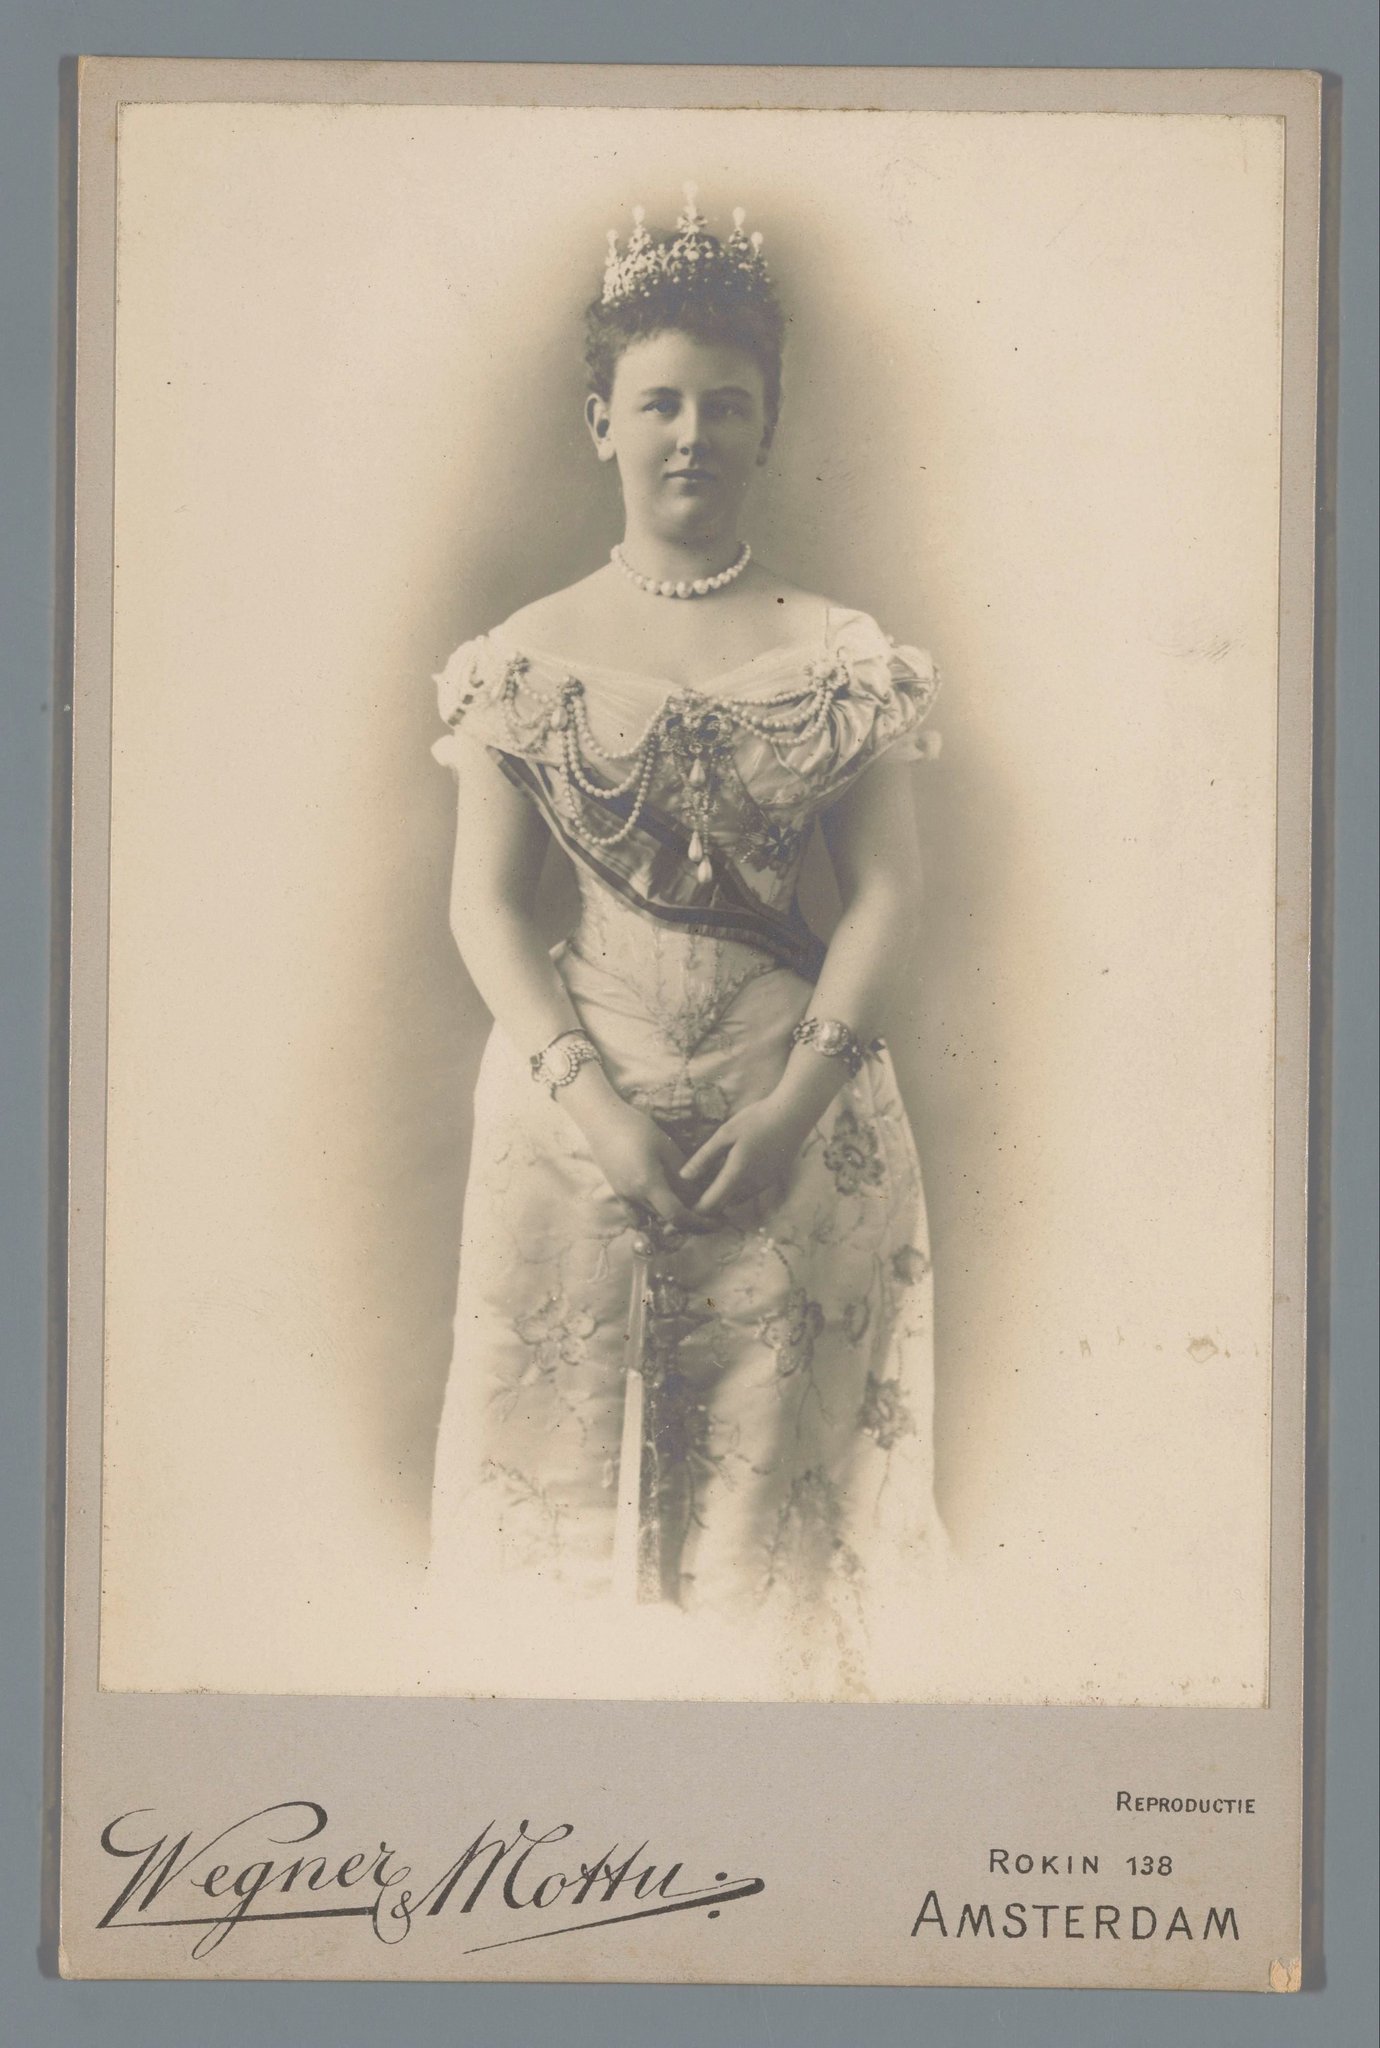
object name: cabinet photograph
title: Portret van koningin Wilhelmina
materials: cardboard, photographic support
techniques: gelatin silver print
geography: amsterdam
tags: the hague, print maker, wilhelmina of the netherlands, historical persons, queen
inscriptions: number: ‘40’, inscription: ‘December 1900?/ Wilhelmina/ 1899’, inscription: ‘REPRODUCTIE/ ROKIN 138/ AMSTERDAM’, stamp: ‘M. M. OLIVIER/ Rokin/ ALGEMEENE BOEKHANDEL/ 70/ AMSTERDAM’